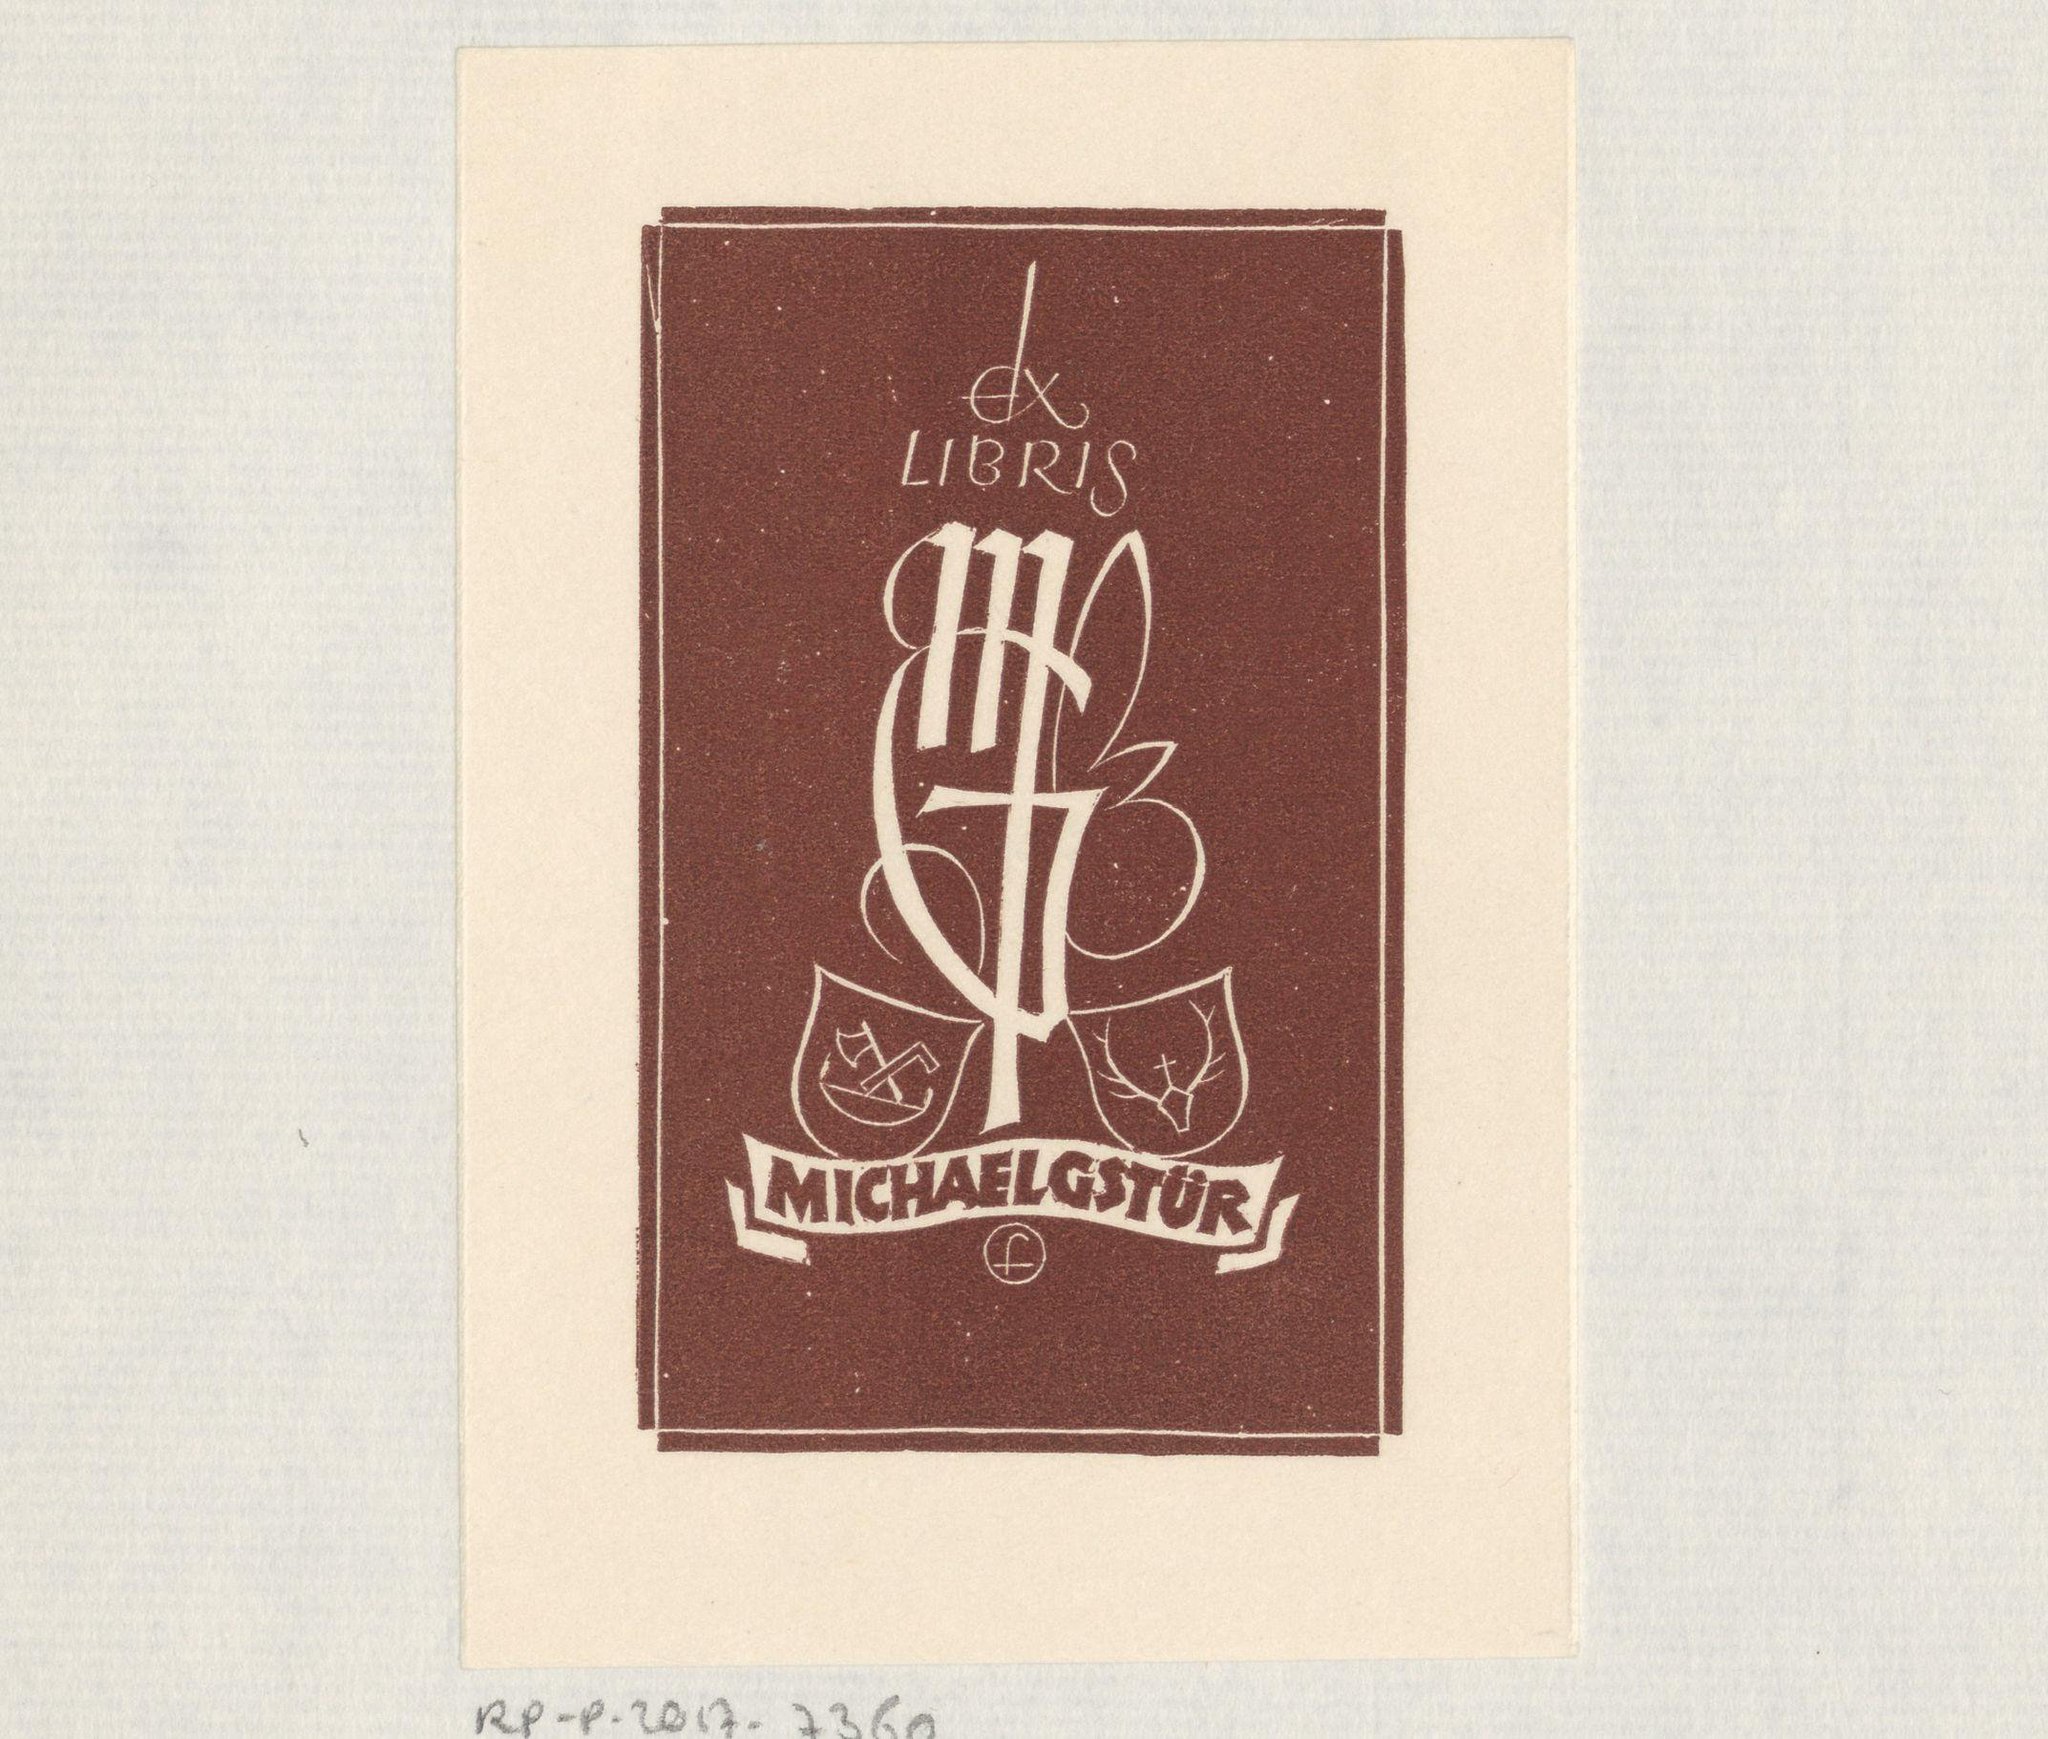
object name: bookplate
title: Ex libris van Michael Gstür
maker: johannes g. freund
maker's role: print maker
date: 1900-1999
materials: paper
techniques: engraving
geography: austria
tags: armorial bearing, heraldry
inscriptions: inscription: ‘J.G. Freund’